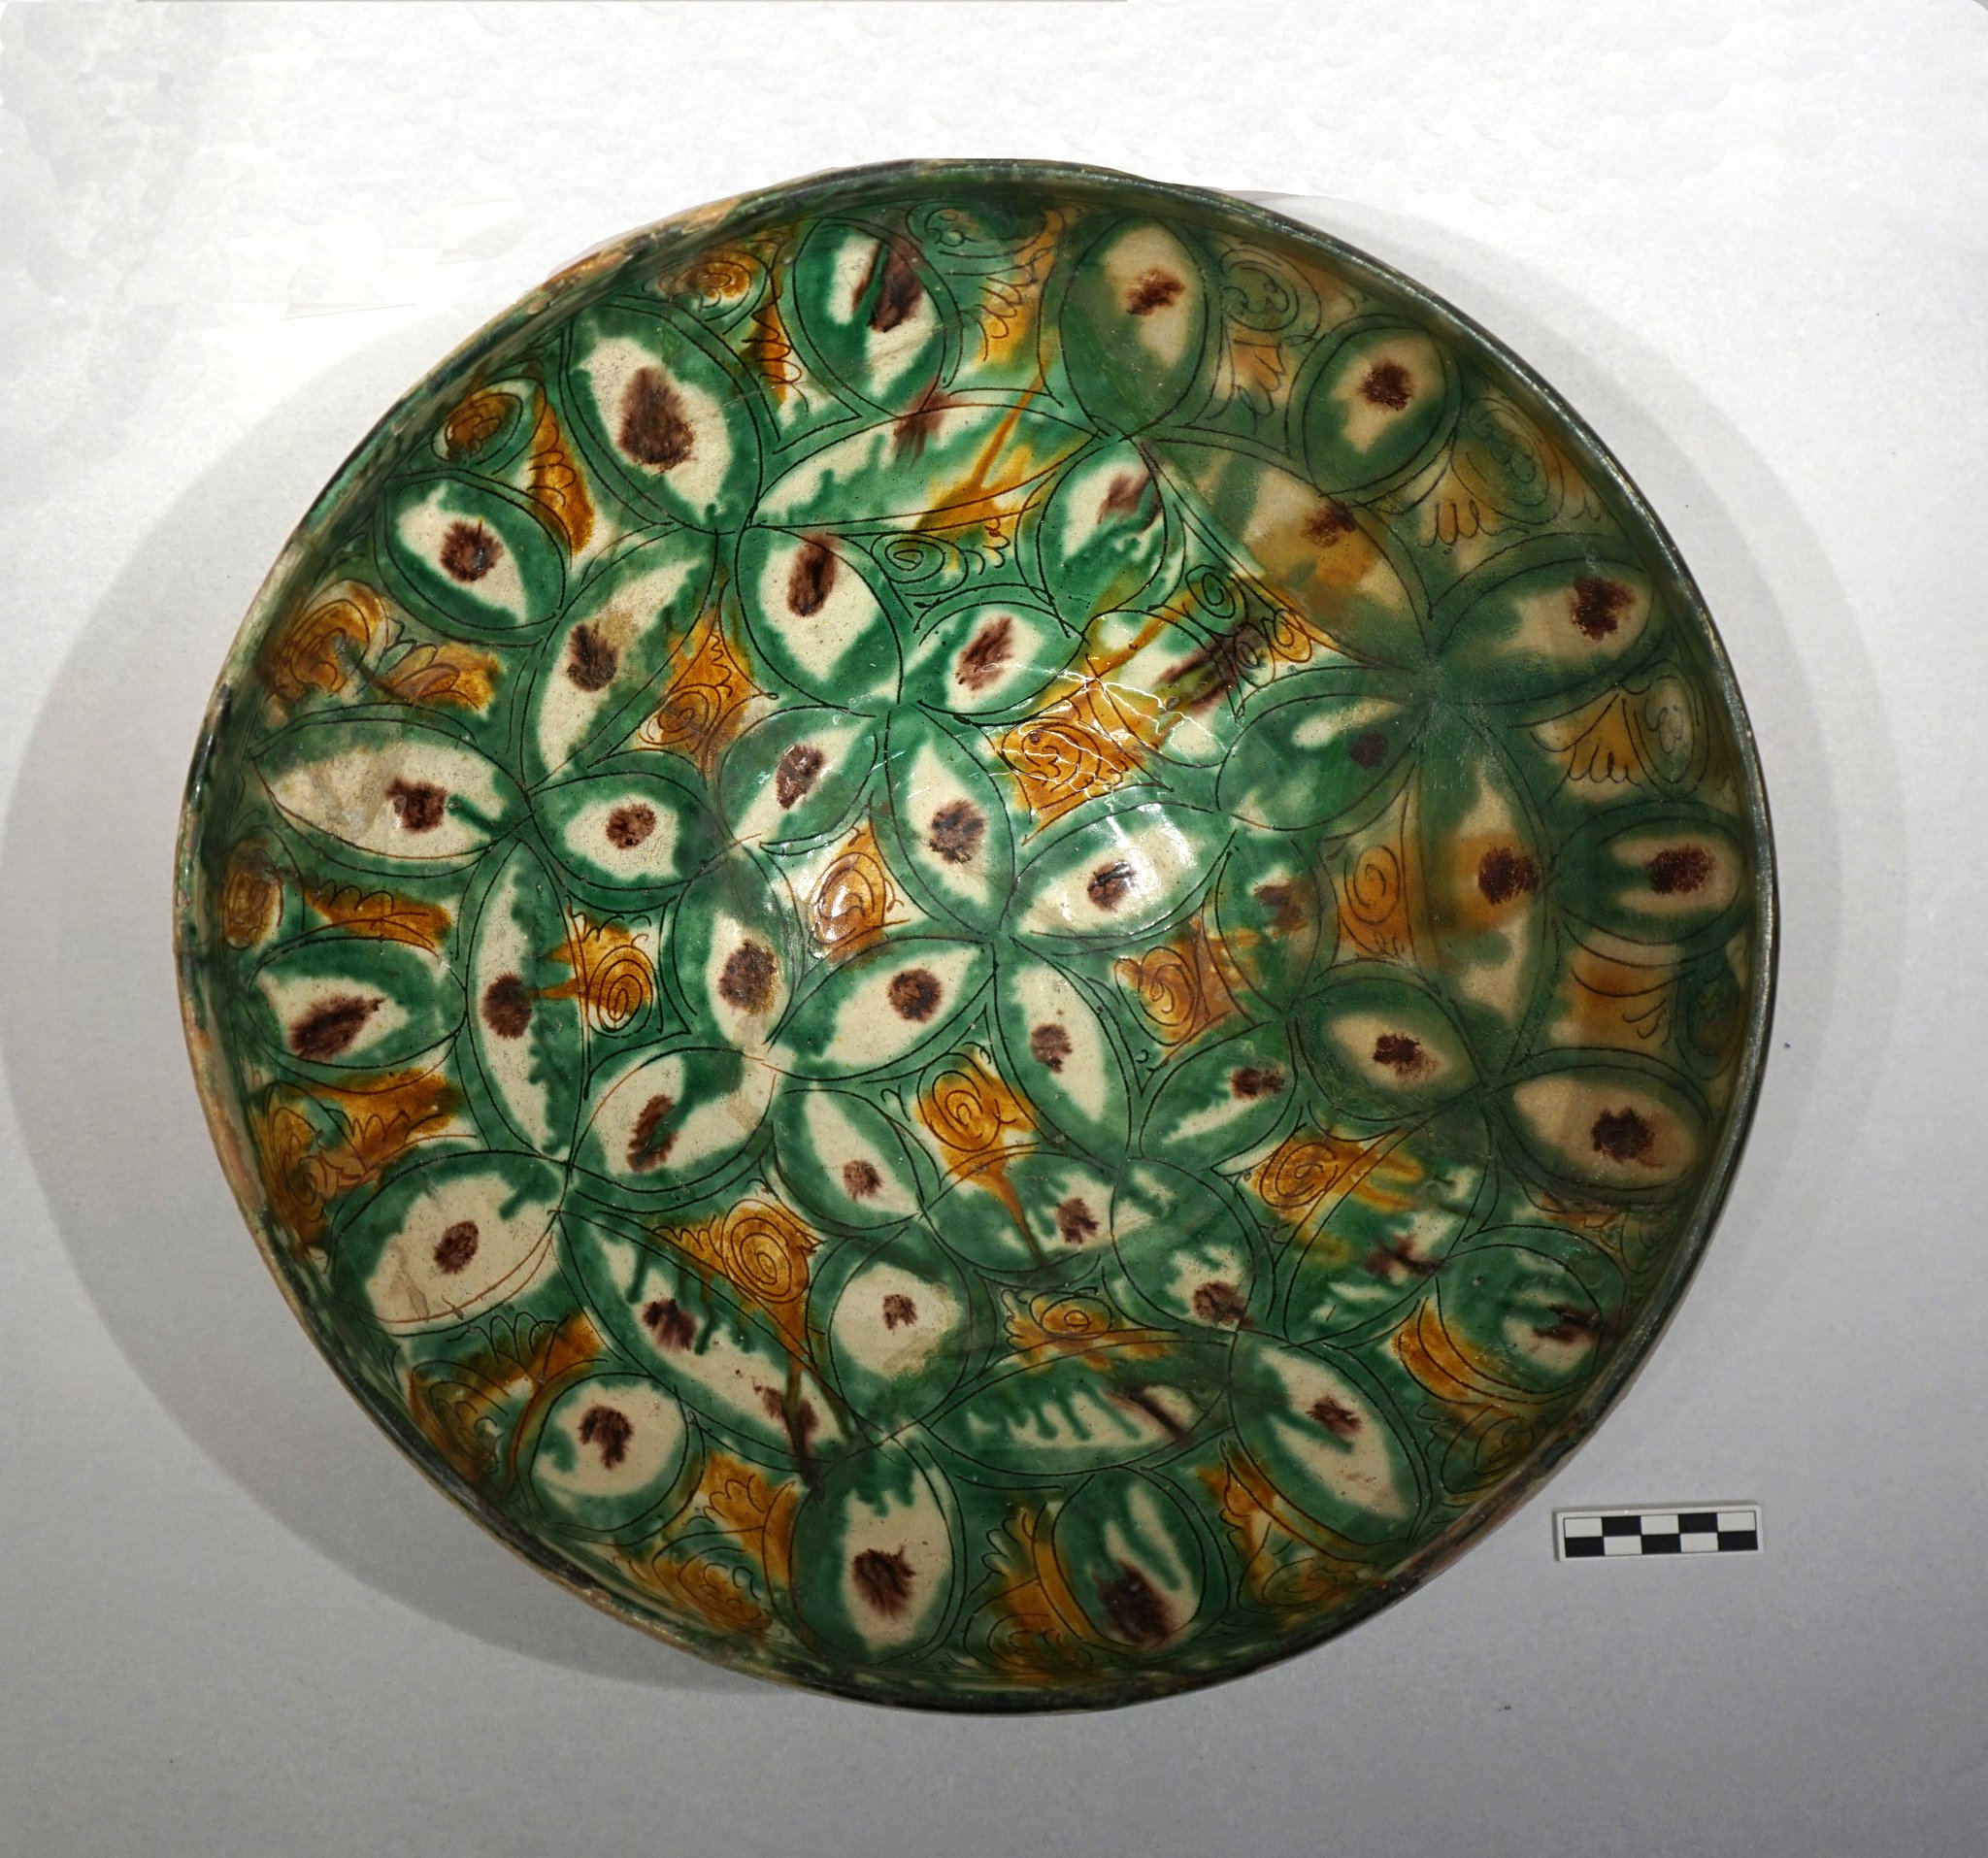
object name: bowl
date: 801-1000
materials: earthenware, glaze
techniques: incising, polychrome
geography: iran